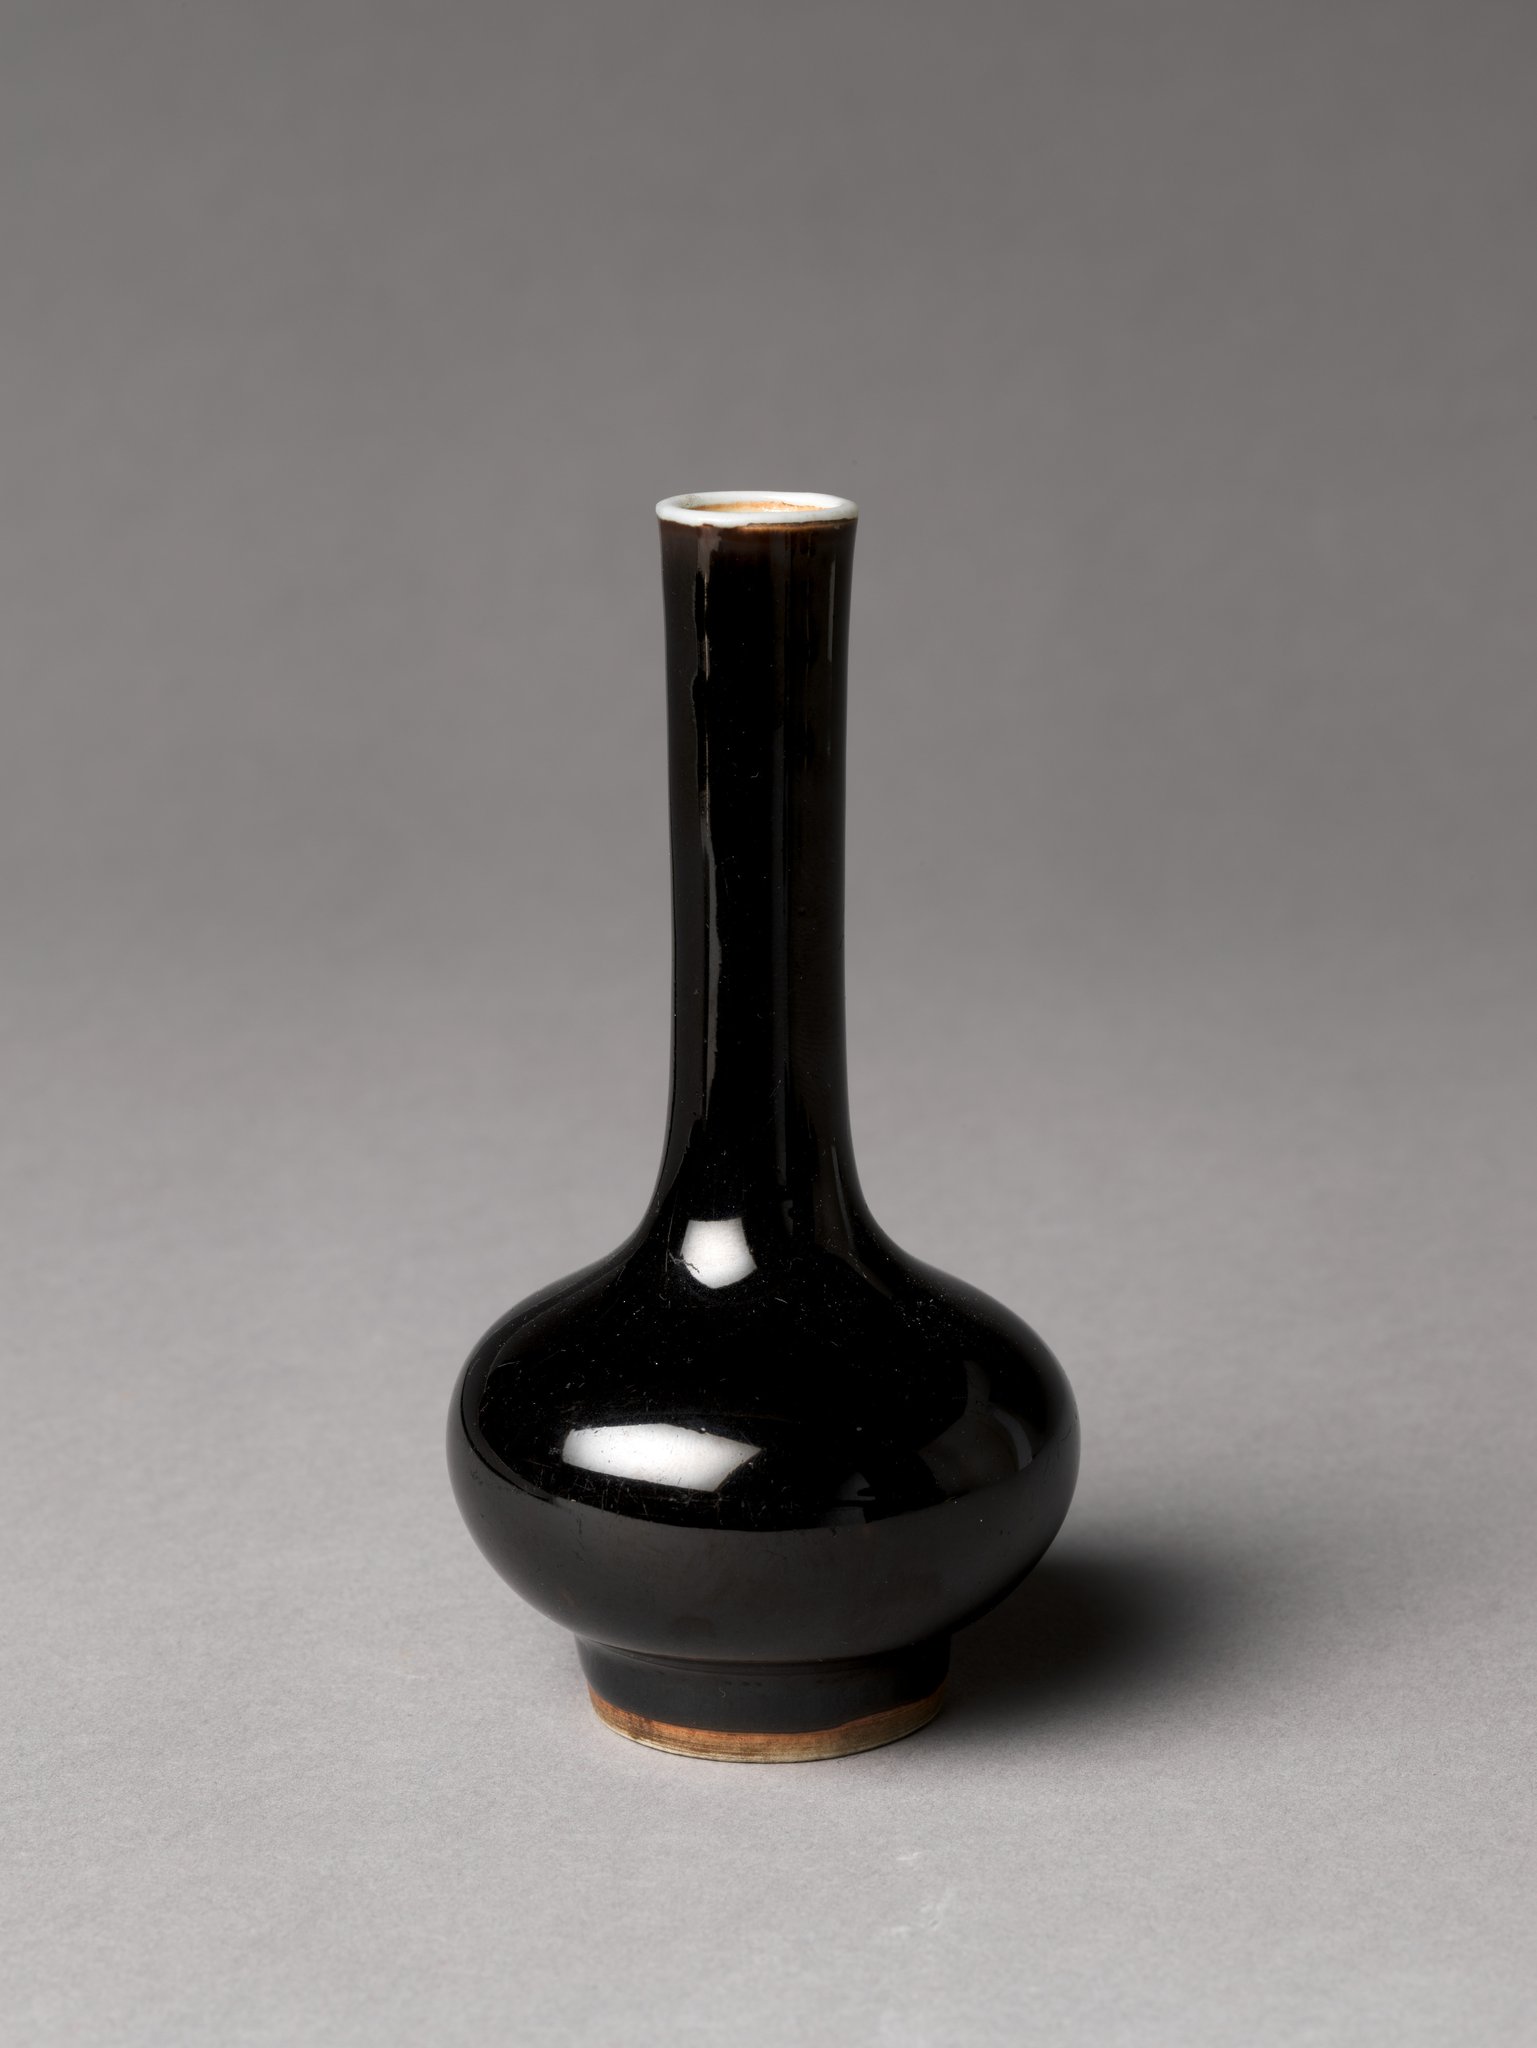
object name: vase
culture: chinese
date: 1701-1733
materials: glaze, porcelain